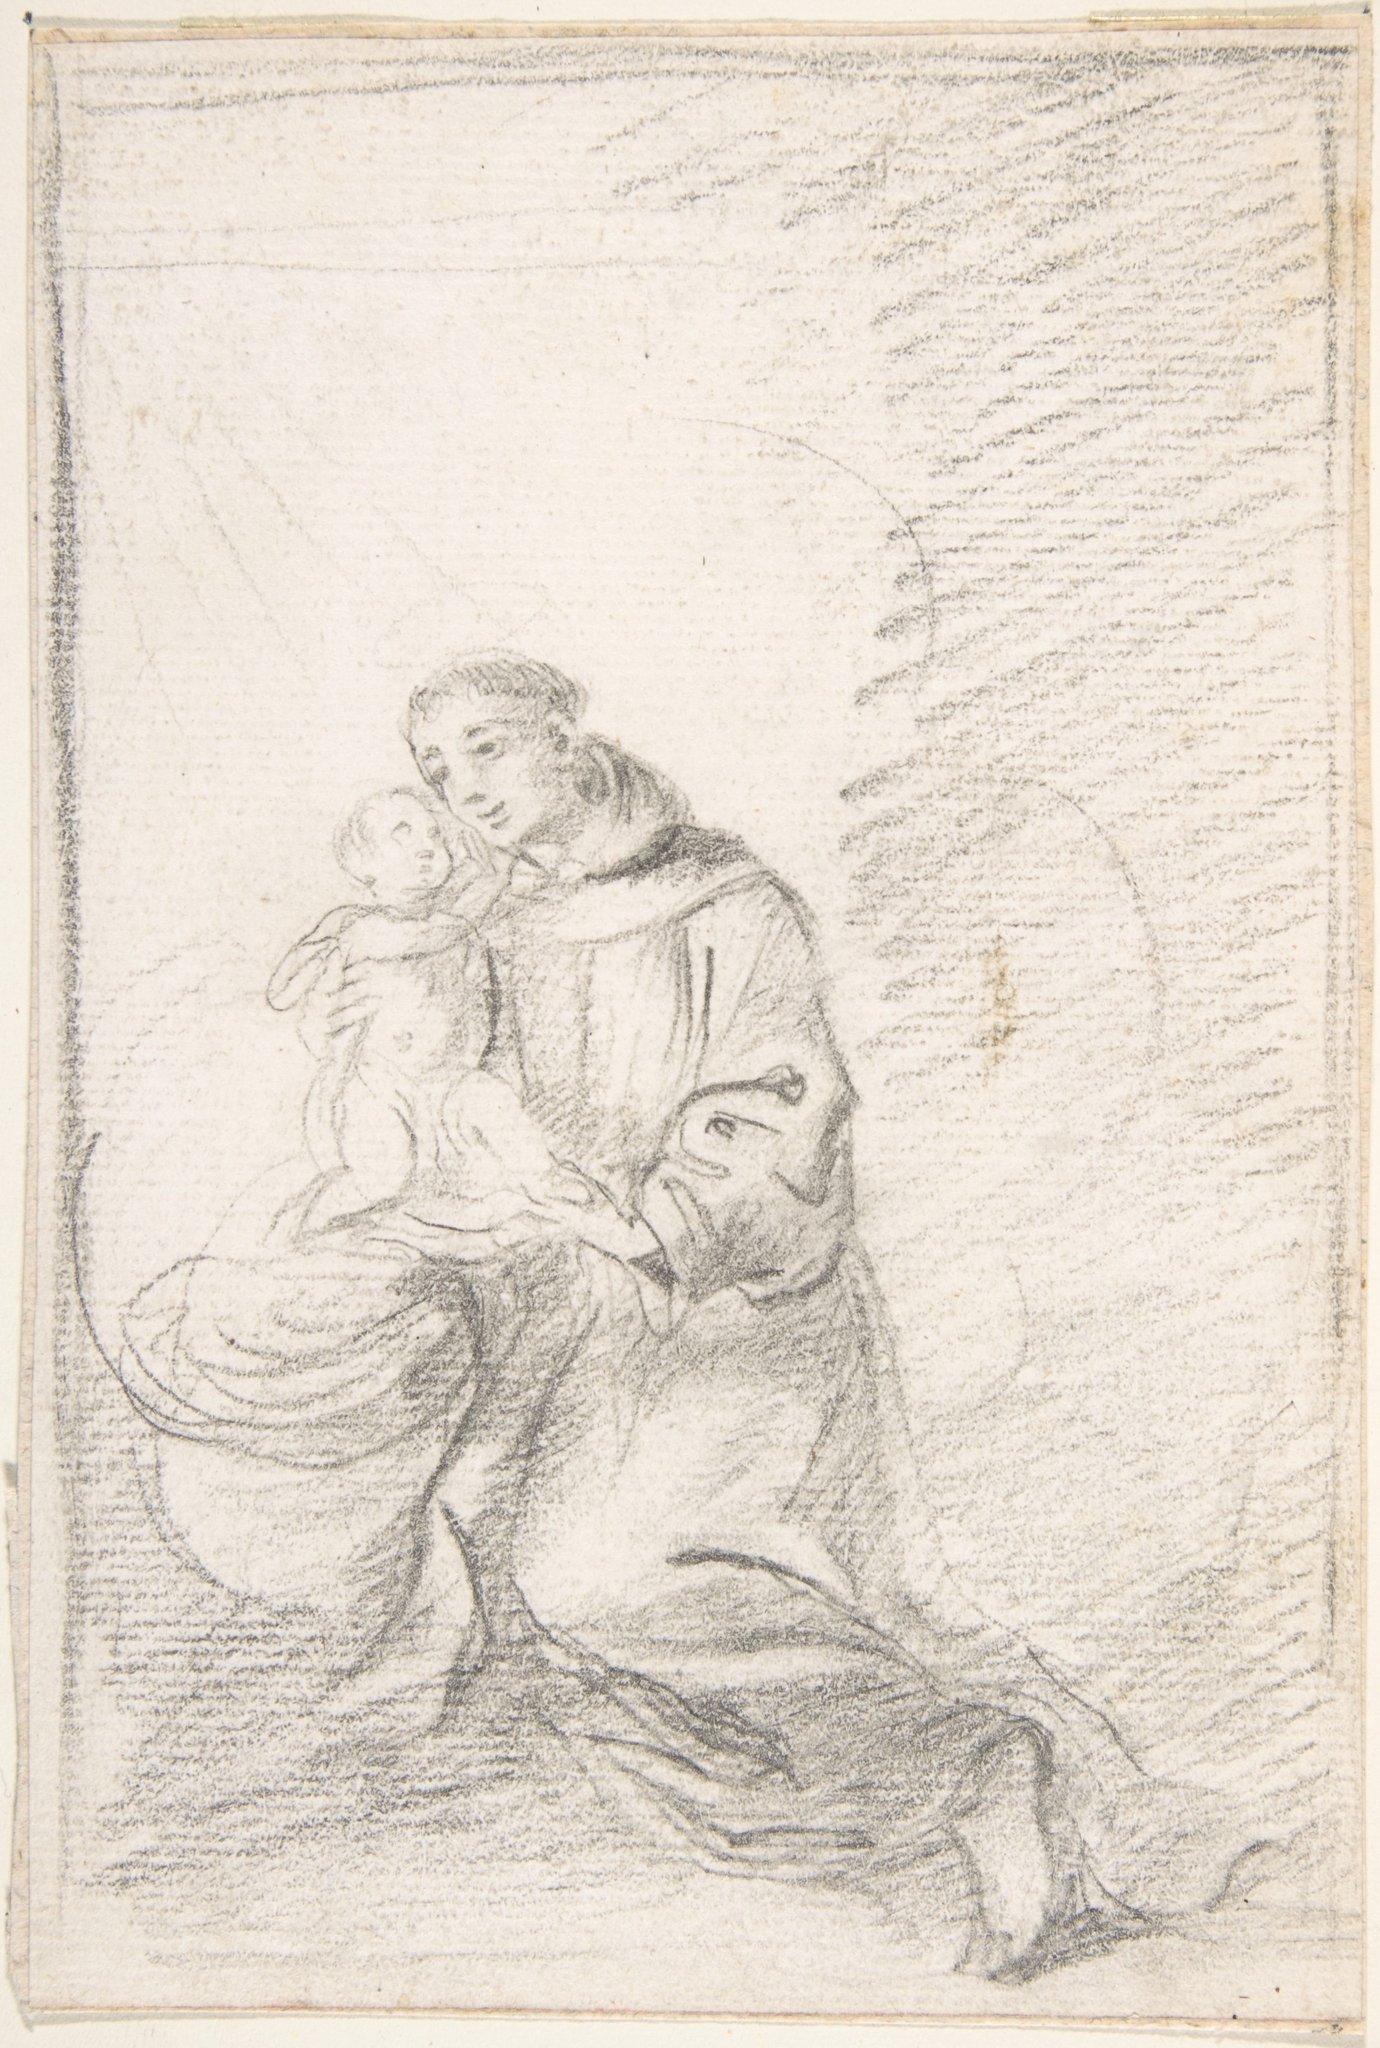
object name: drawing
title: Saint Anthony of Padua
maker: pedro duque cornejo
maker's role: artist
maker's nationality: spanish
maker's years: 1677-1757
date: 1700-1750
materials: chalk, ivory, paper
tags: infants,saint anthony